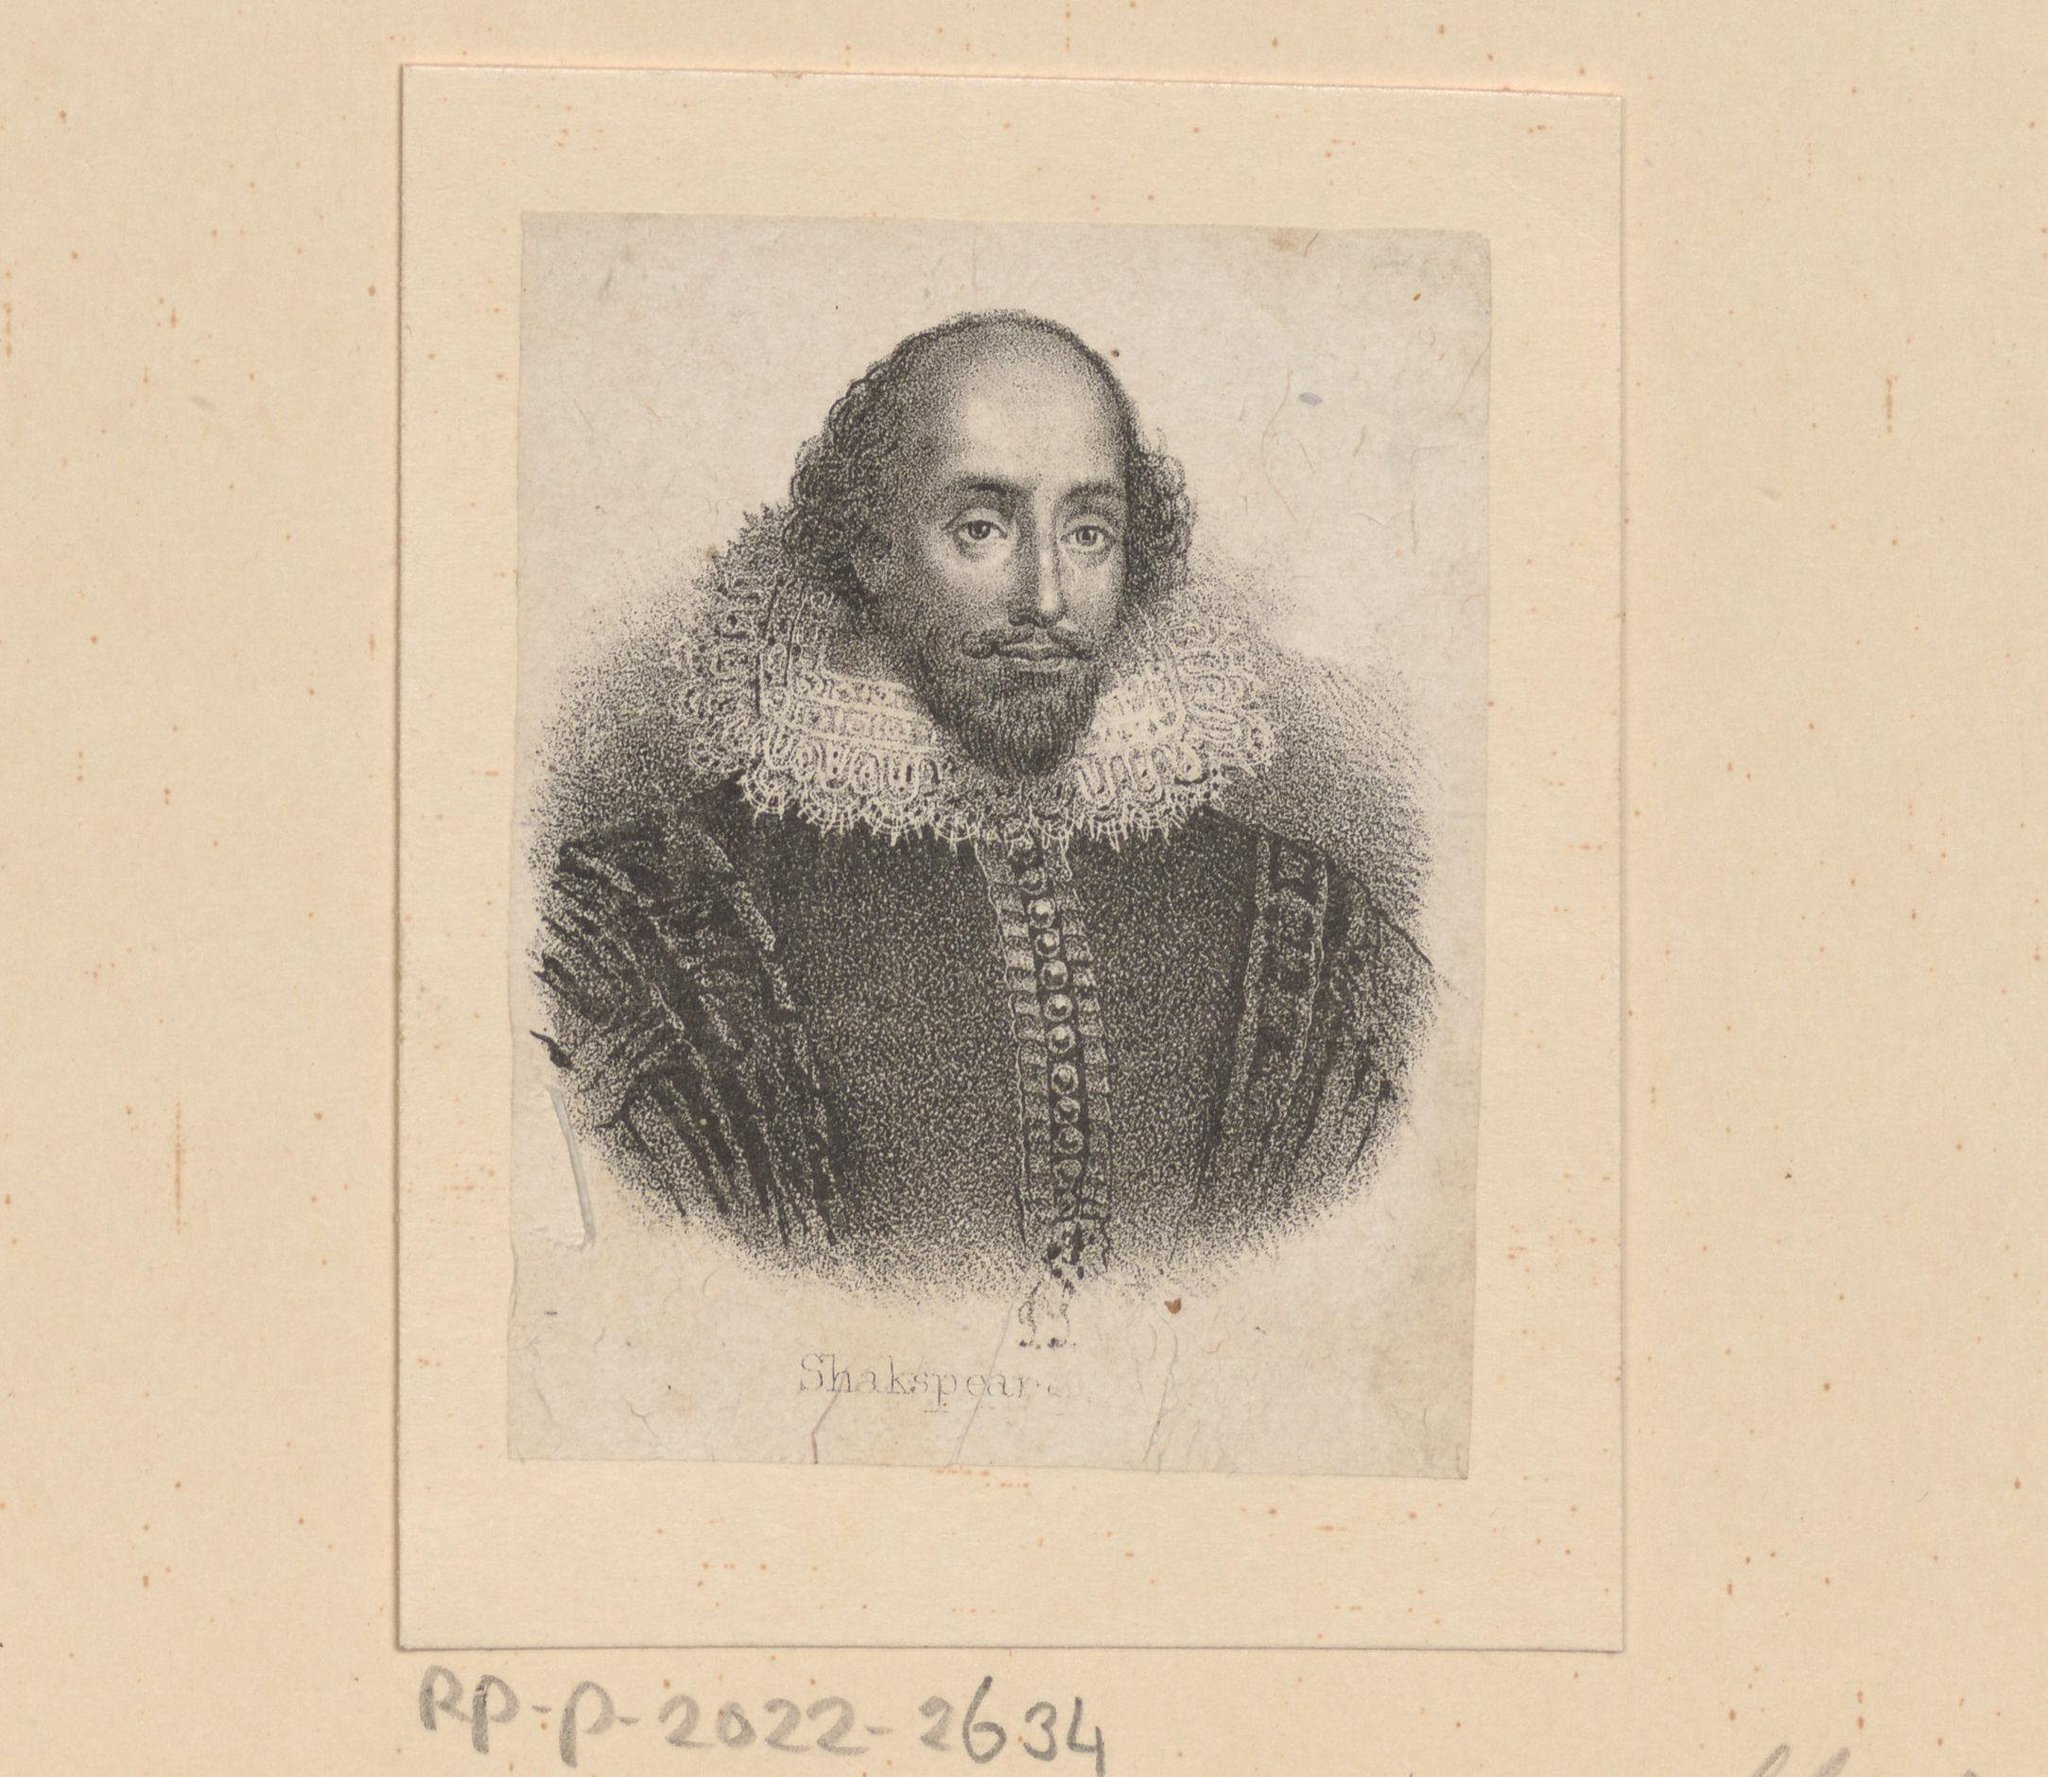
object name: print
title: Portret van William Shakespeare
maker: Anonymous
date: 1798-1899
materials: paper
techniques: lithograph, snipping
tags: william shakespeare, historical persons, portrait of a writer